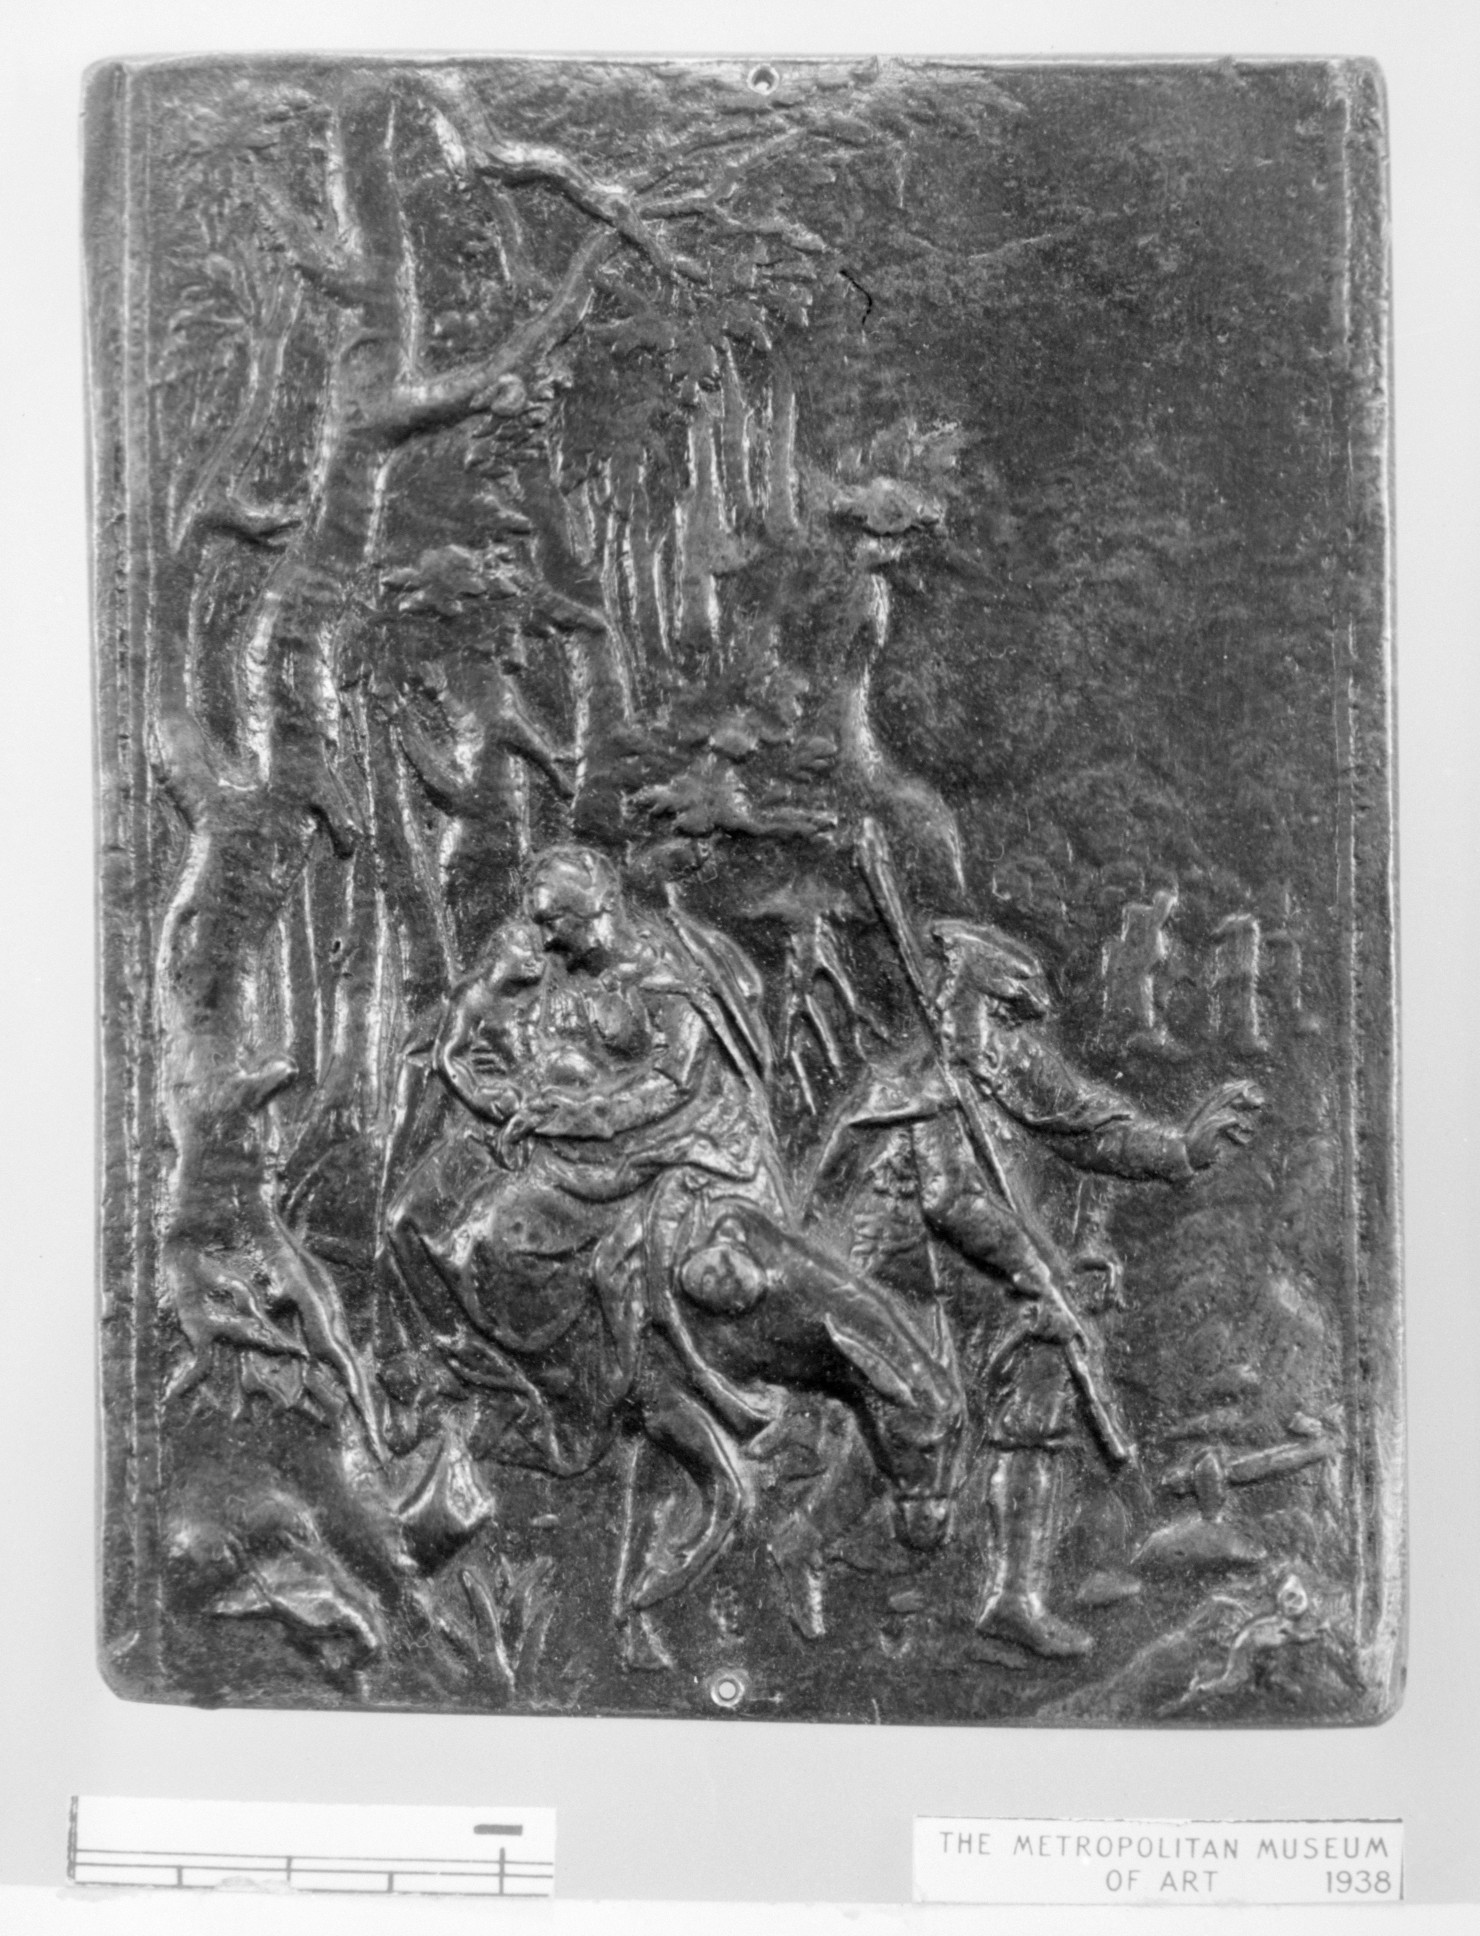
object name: plaquette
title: The Flight into Egypt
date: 1567-1633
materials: bronze, patina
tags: human figures,donkeys,holy family